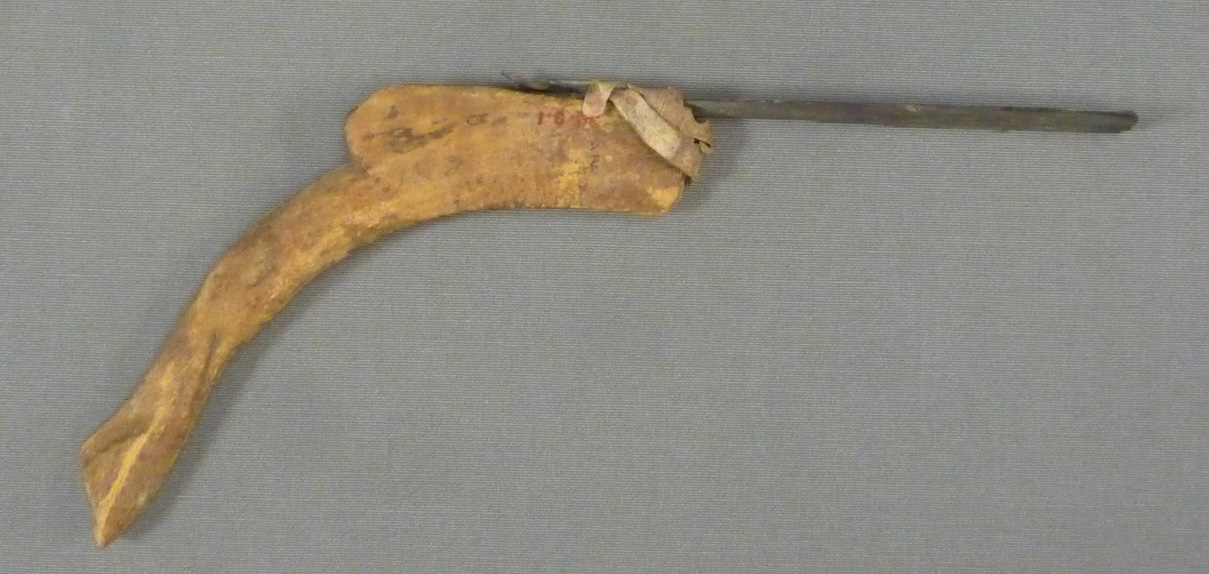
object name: model adze, hatshepsut, foundation deposit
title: Model Adze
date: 1479-1458 BCE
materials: bronze, copper alloy, leather, wood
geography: egypt